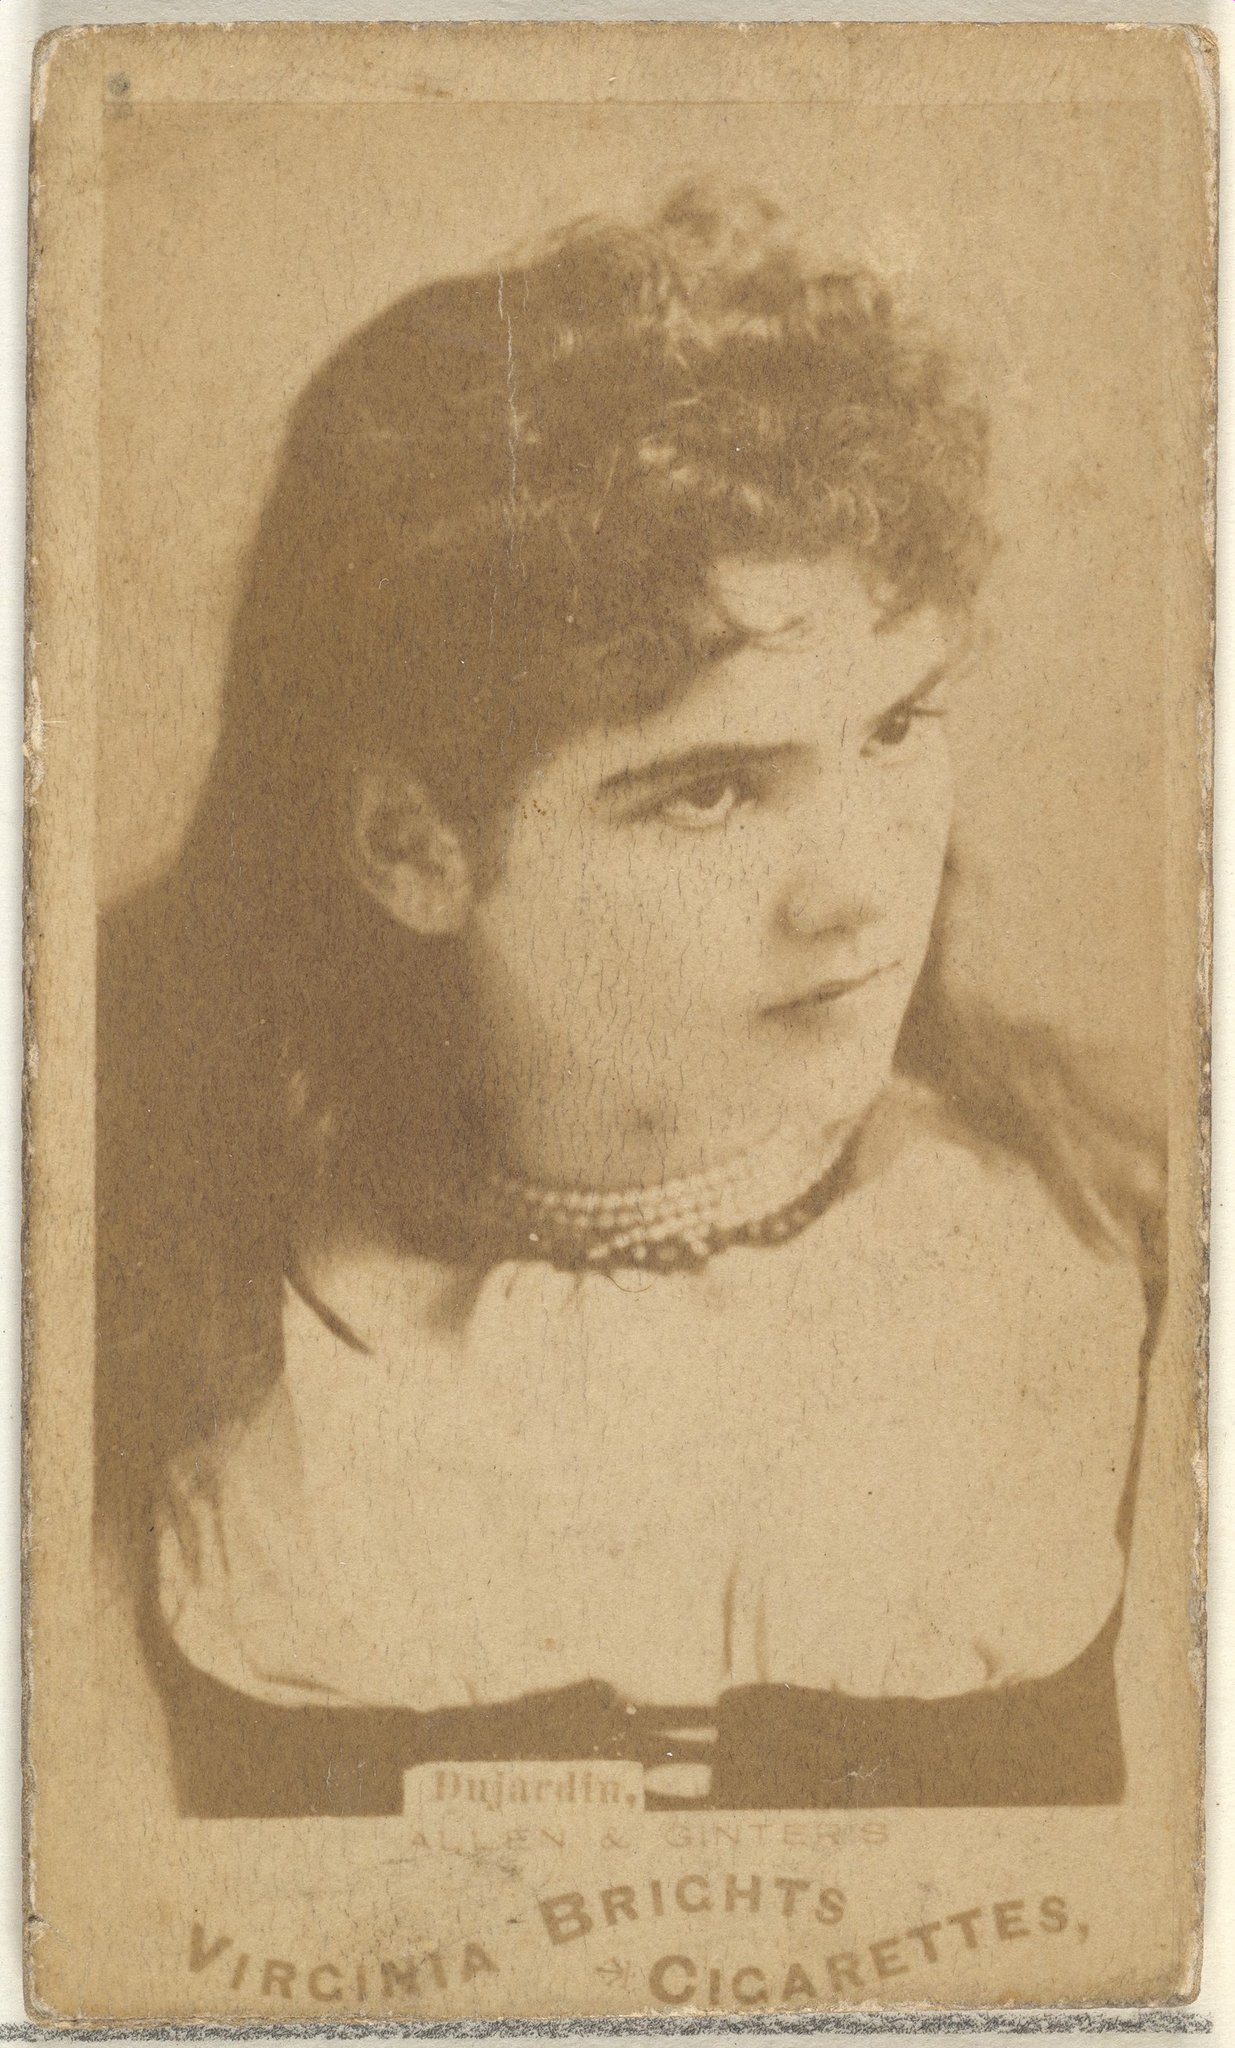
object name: photograph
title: Bujardia, from the Actors and Actresses series (N45, Type 1) for Virginia Brights Cigarettes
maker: allen & ginter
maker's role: publisher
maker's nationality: american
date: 1888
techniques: albumen silver print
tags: portraits,women,actresses